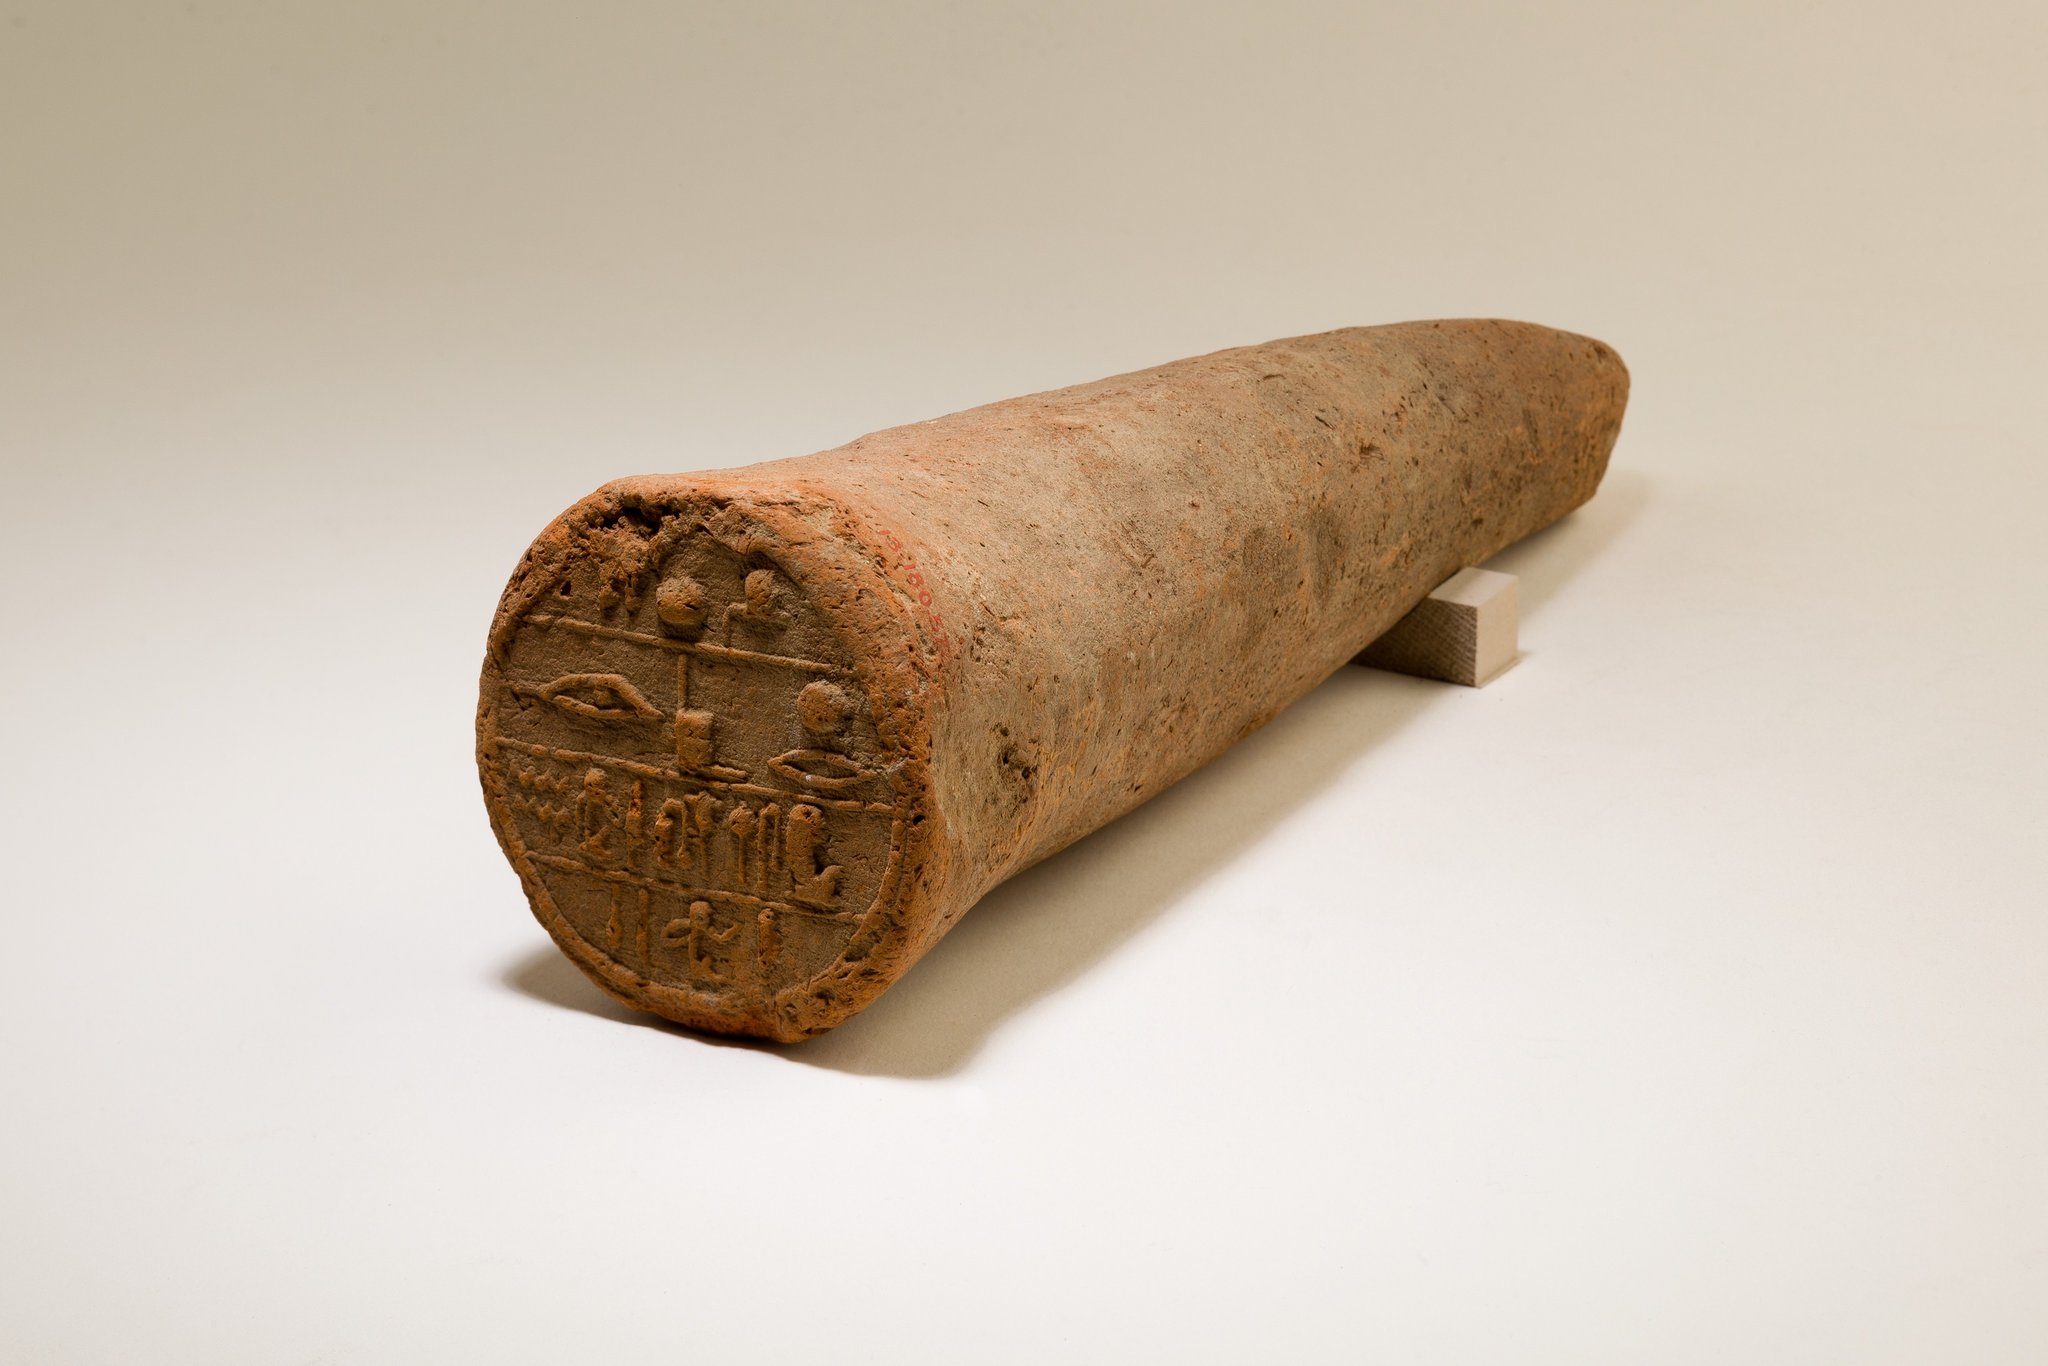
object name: cone, curcular impression, ineni, inspector of scribe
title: Funerary Cone of the Inspector of Scribes Ineni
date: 1550-1295 BCE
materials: pottery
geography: egypt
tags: hieroglyphs